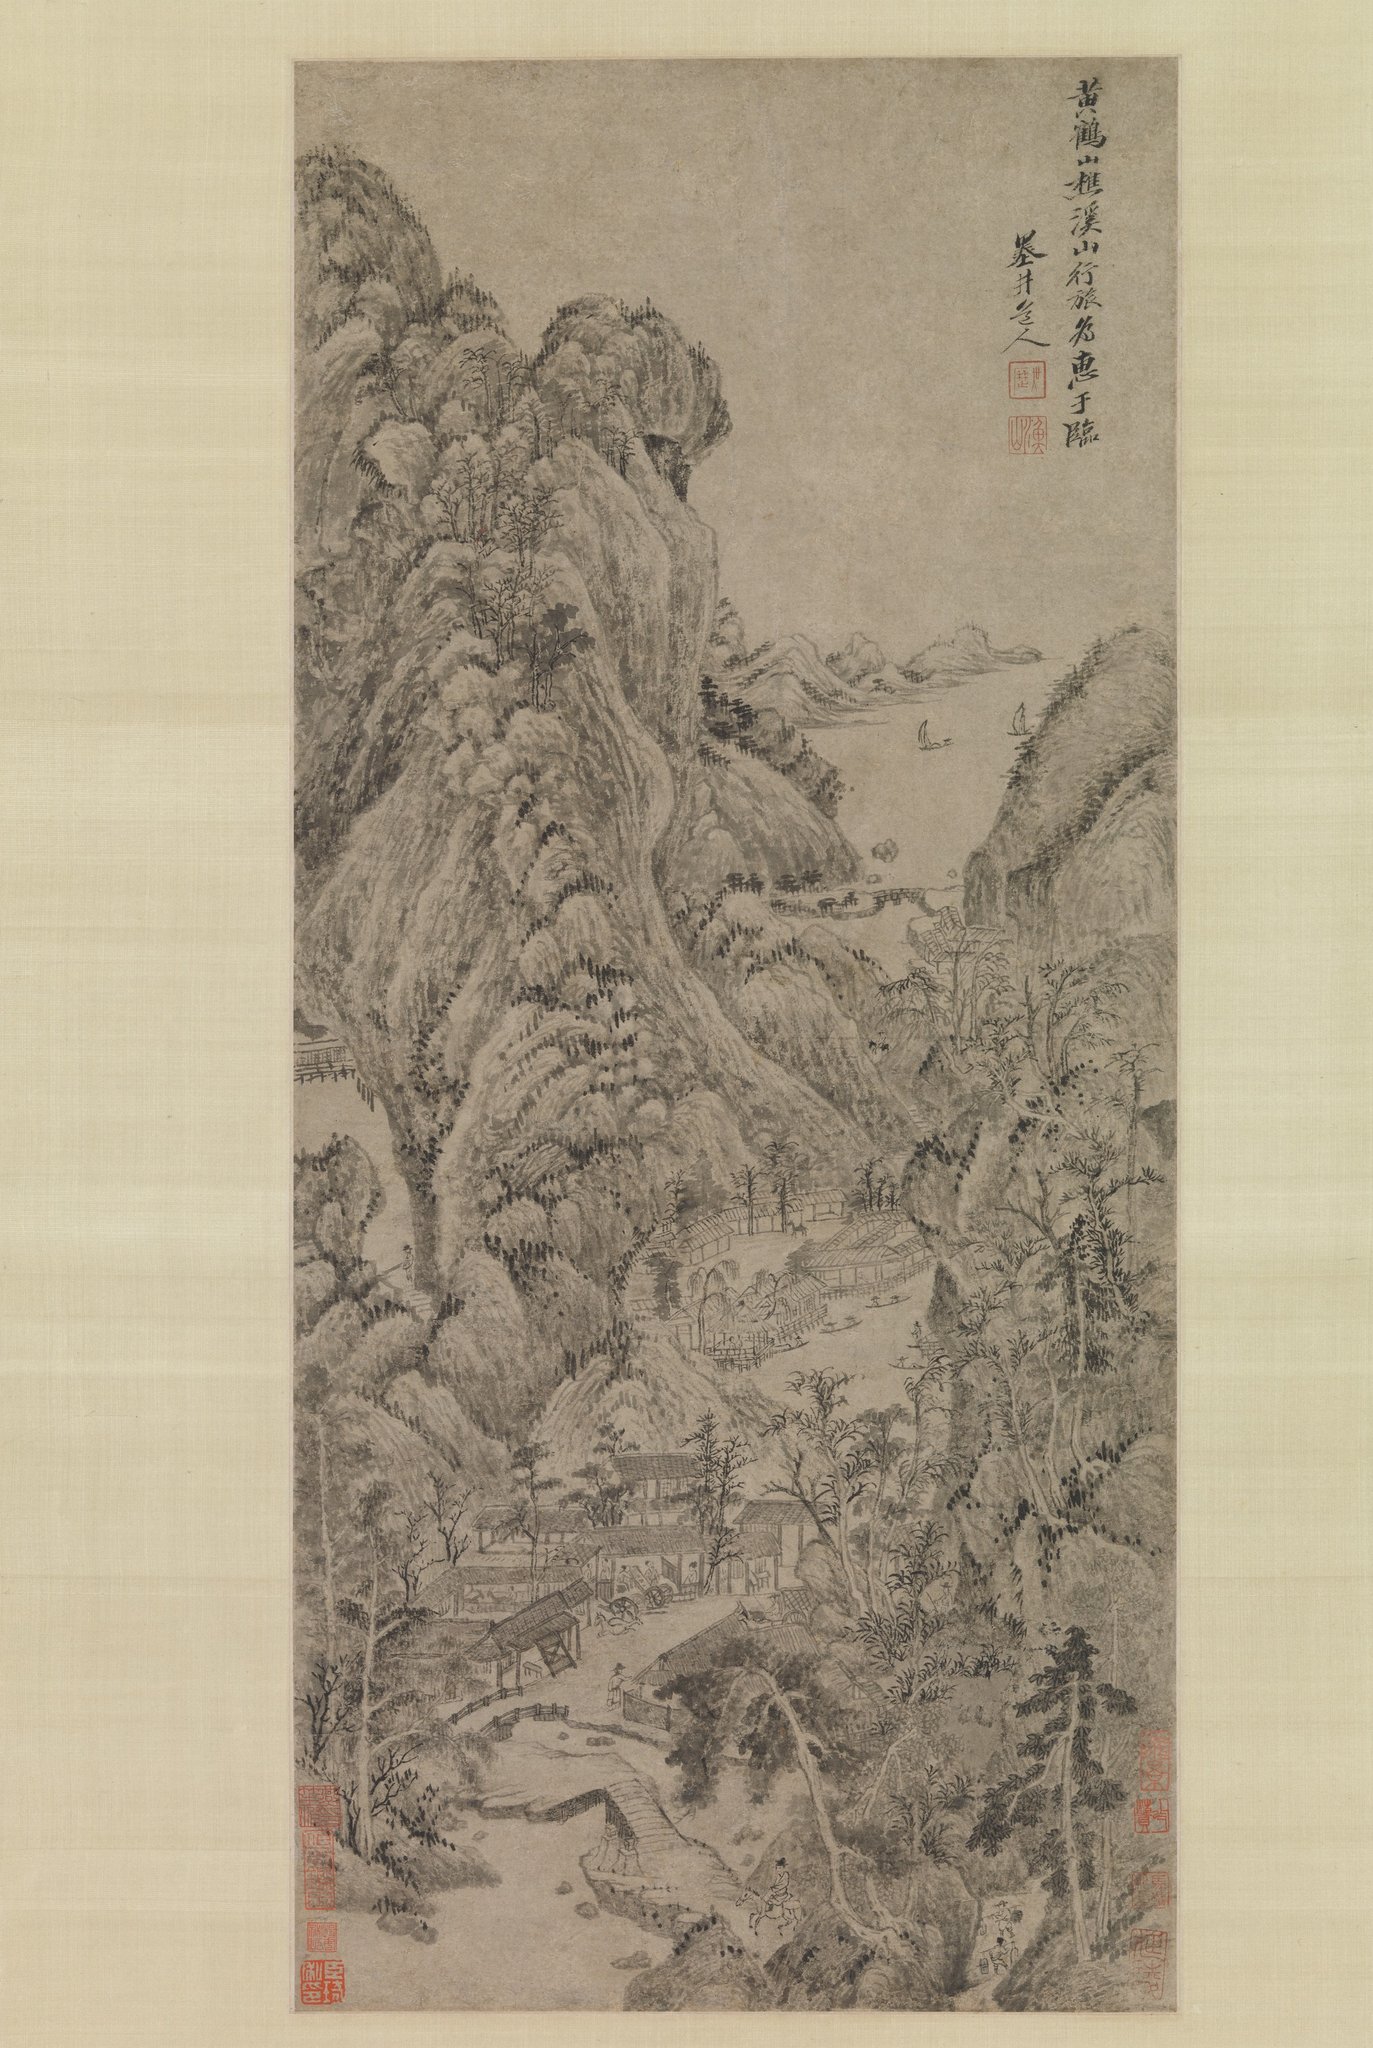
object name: hanging scroll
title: Travelers among Streams and Mountains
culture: chinese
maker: wu li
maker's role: artist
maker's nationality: chinese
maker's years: 1632-1718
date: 1670-1679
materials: ink, paper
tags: mountains,landscapes,streams